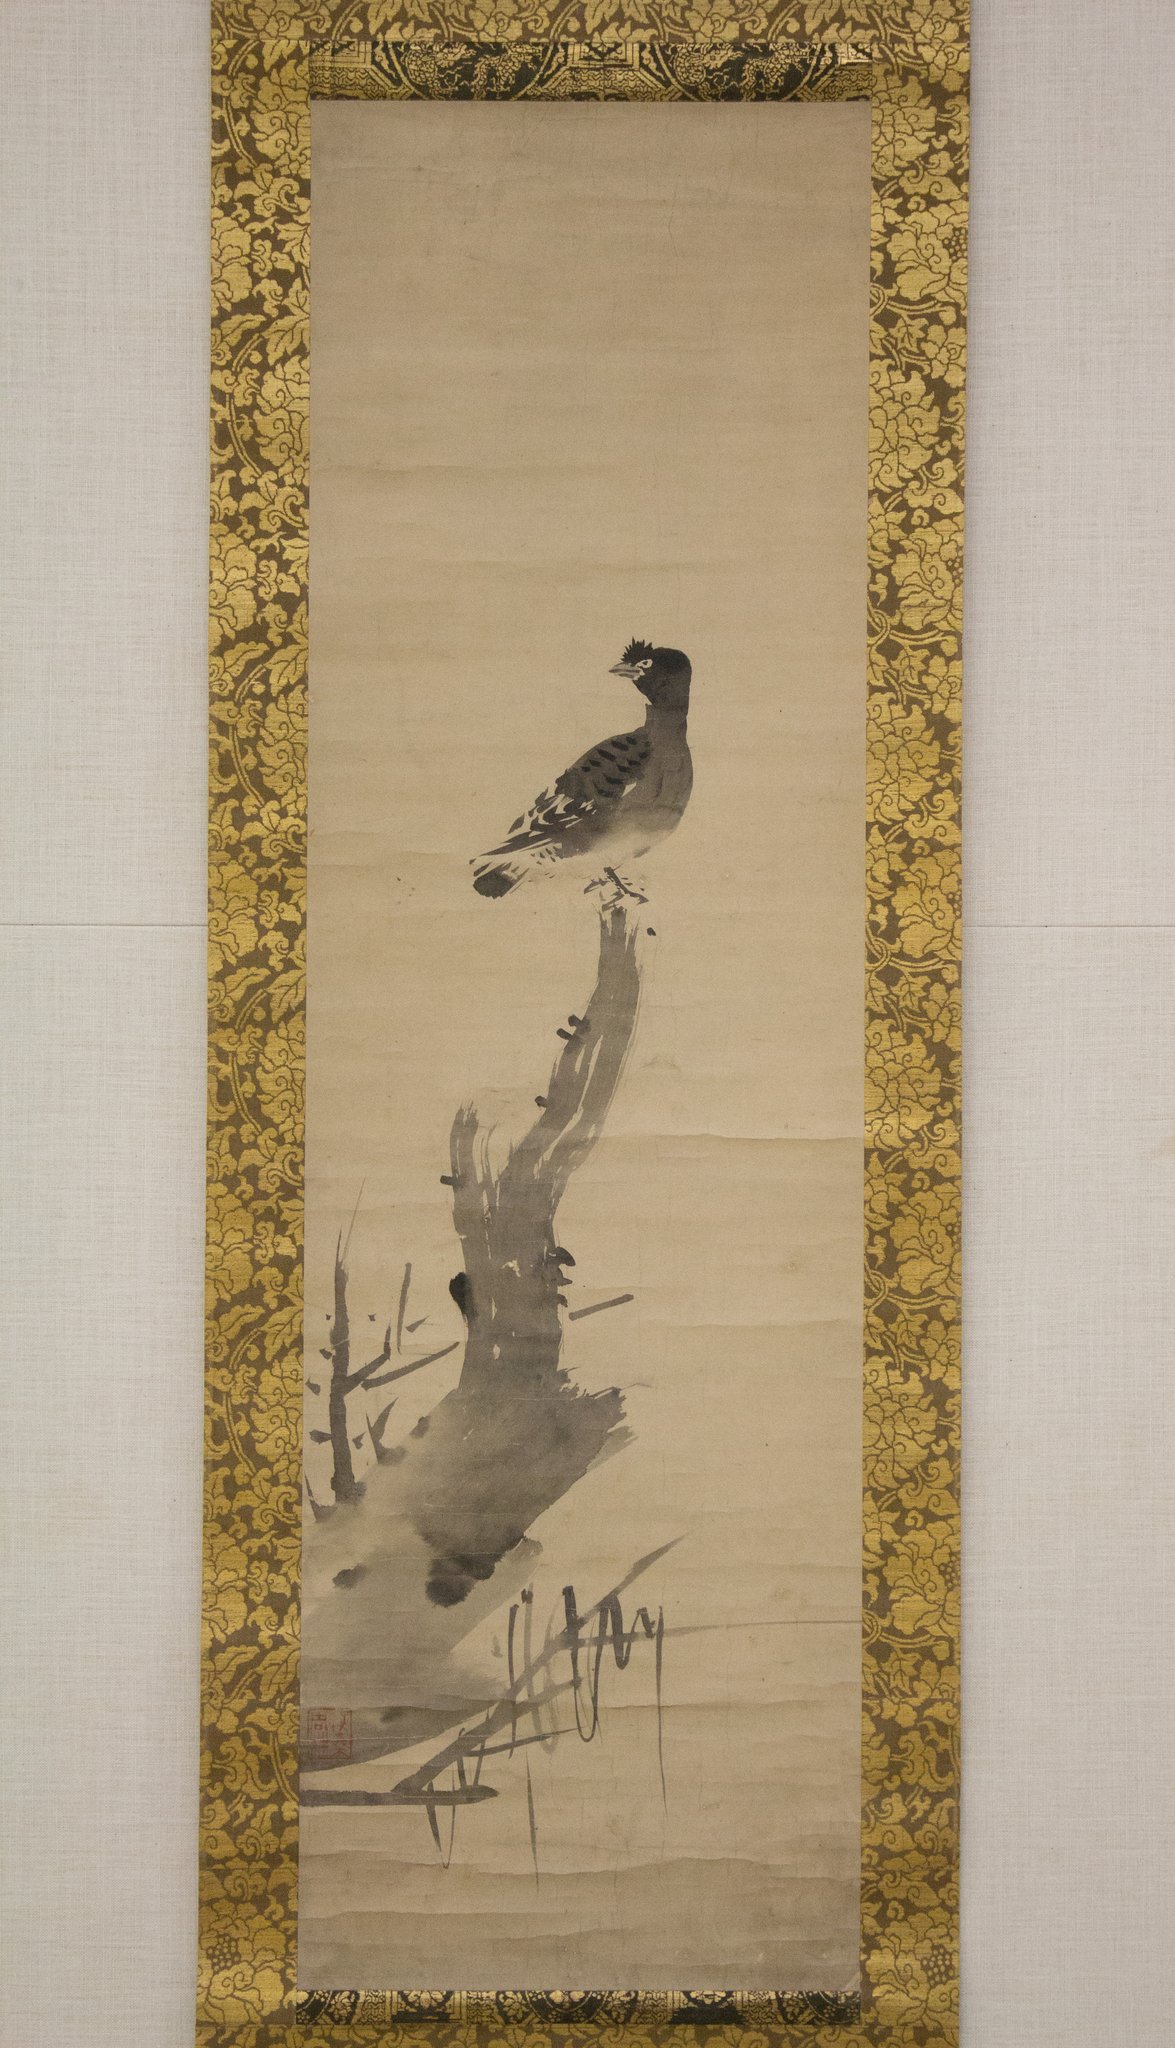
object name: hanging scroll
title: Bird on Tree (Haha-chō)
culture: japanese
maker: shūkō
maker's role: artist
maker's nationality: japanese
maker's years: 1504-1520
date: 1504-1520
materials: ink, paper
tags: birds